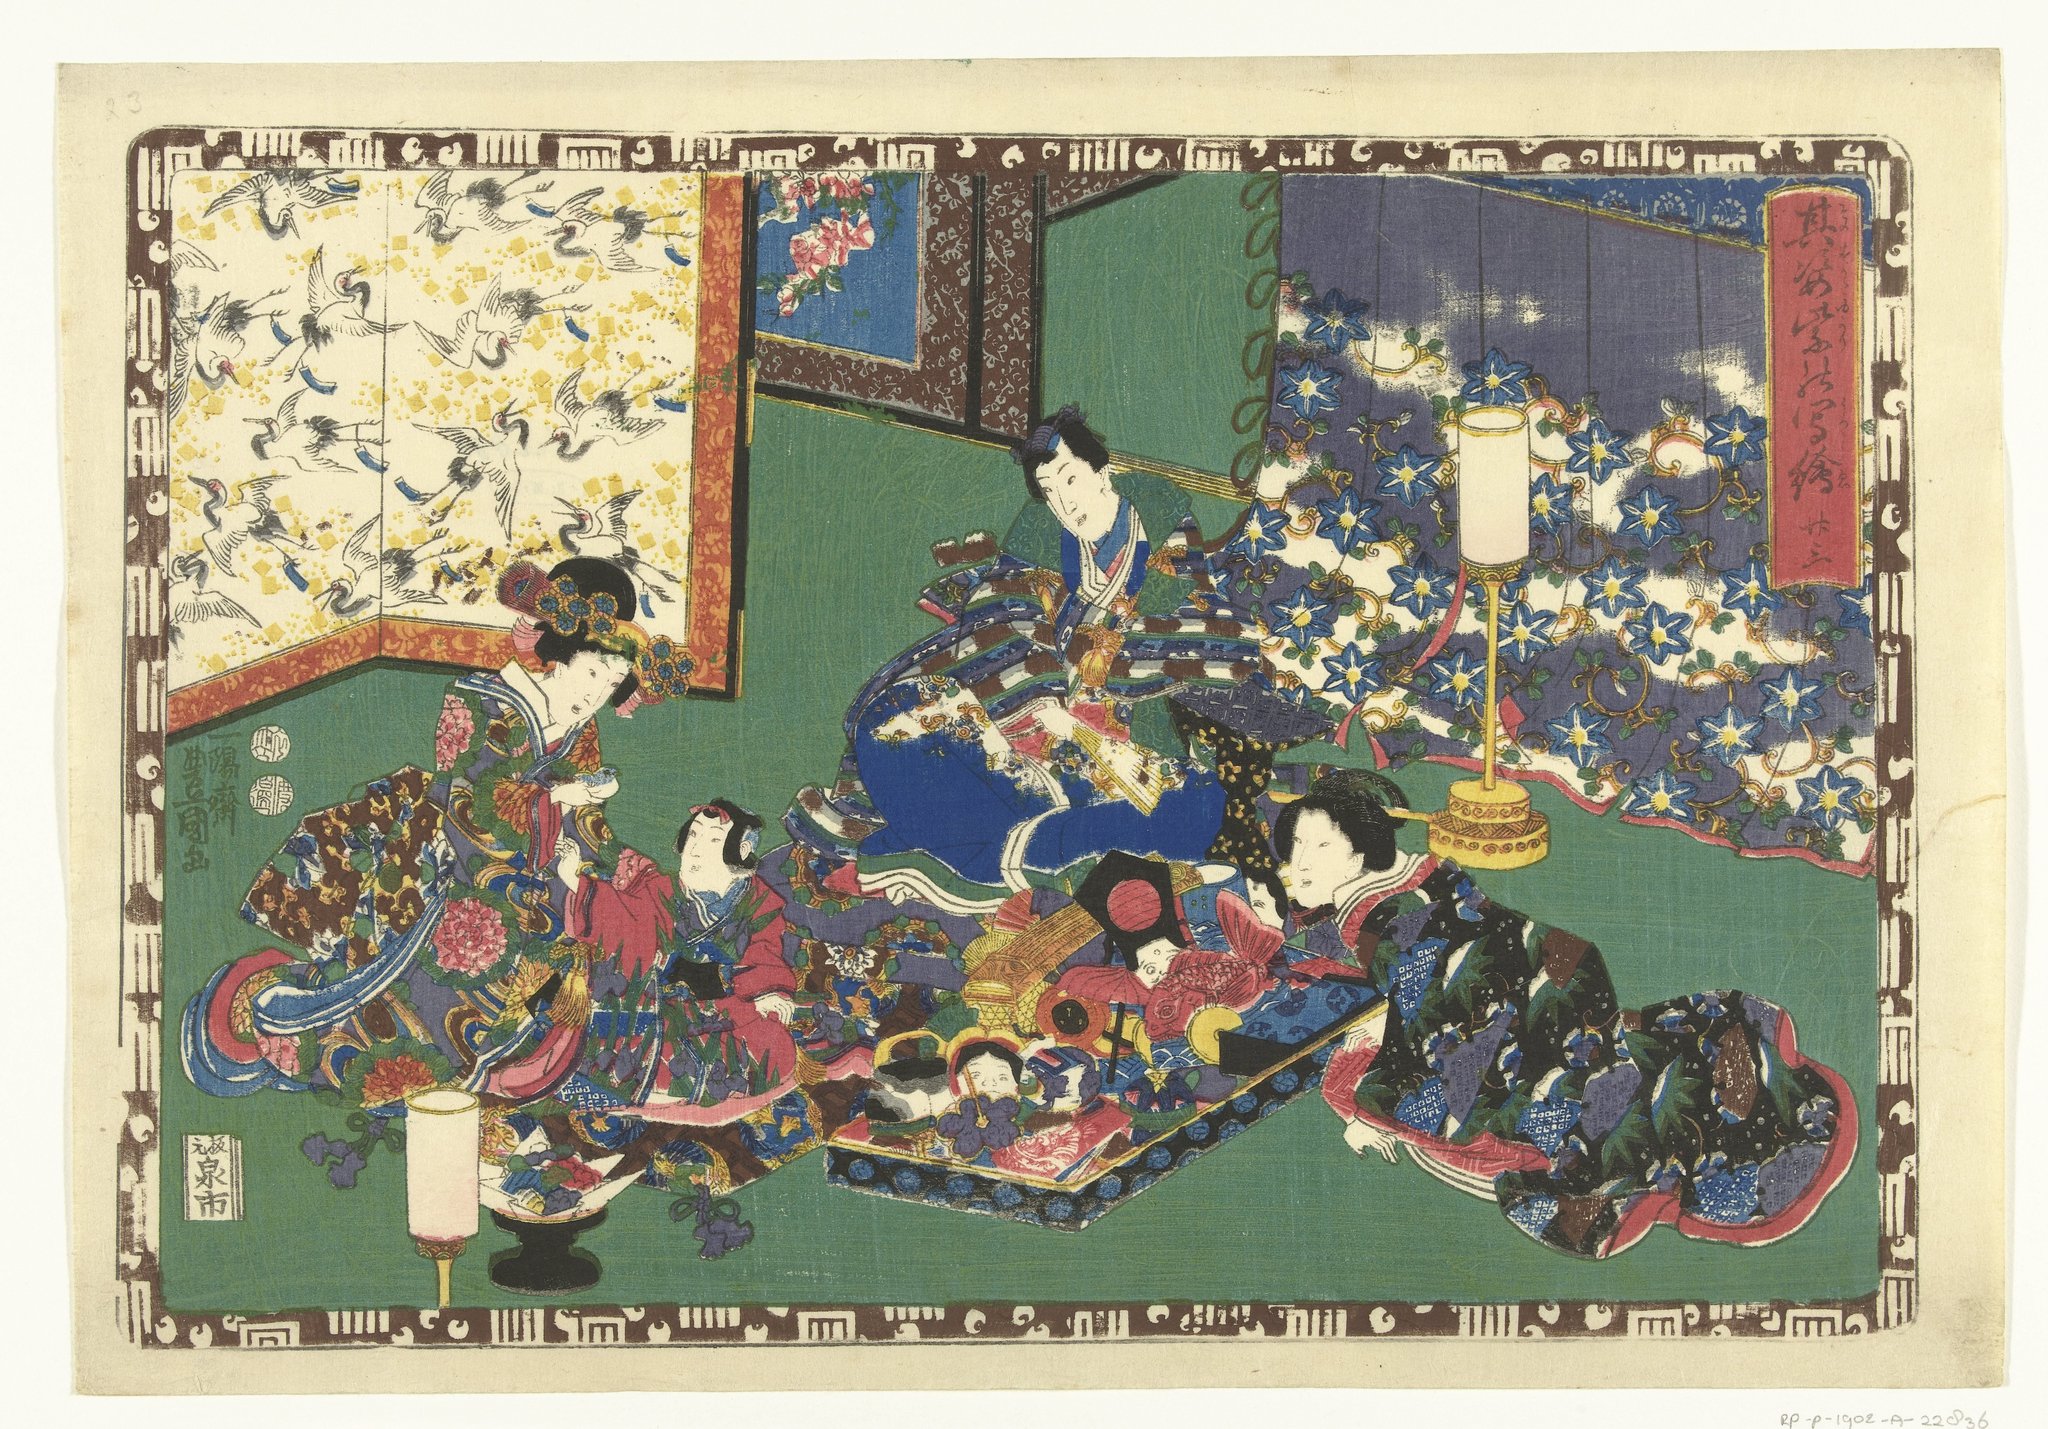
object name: print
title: Getrouwe afbeeldingen van de Schitterende Prins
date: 1849-1850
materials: paper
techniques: woodcut, nishiki e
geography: tokyo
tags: (playing with) toys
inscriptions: collector's mark: Lugt 2228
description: Prins Genji, twee vrouwen en een meisje, zittend rondom grote bak met speelgoed; in kamer met kamerscherm waarop kraanvogels. Voorstelling omsloten door bruine rand waarin Genji emblemen.